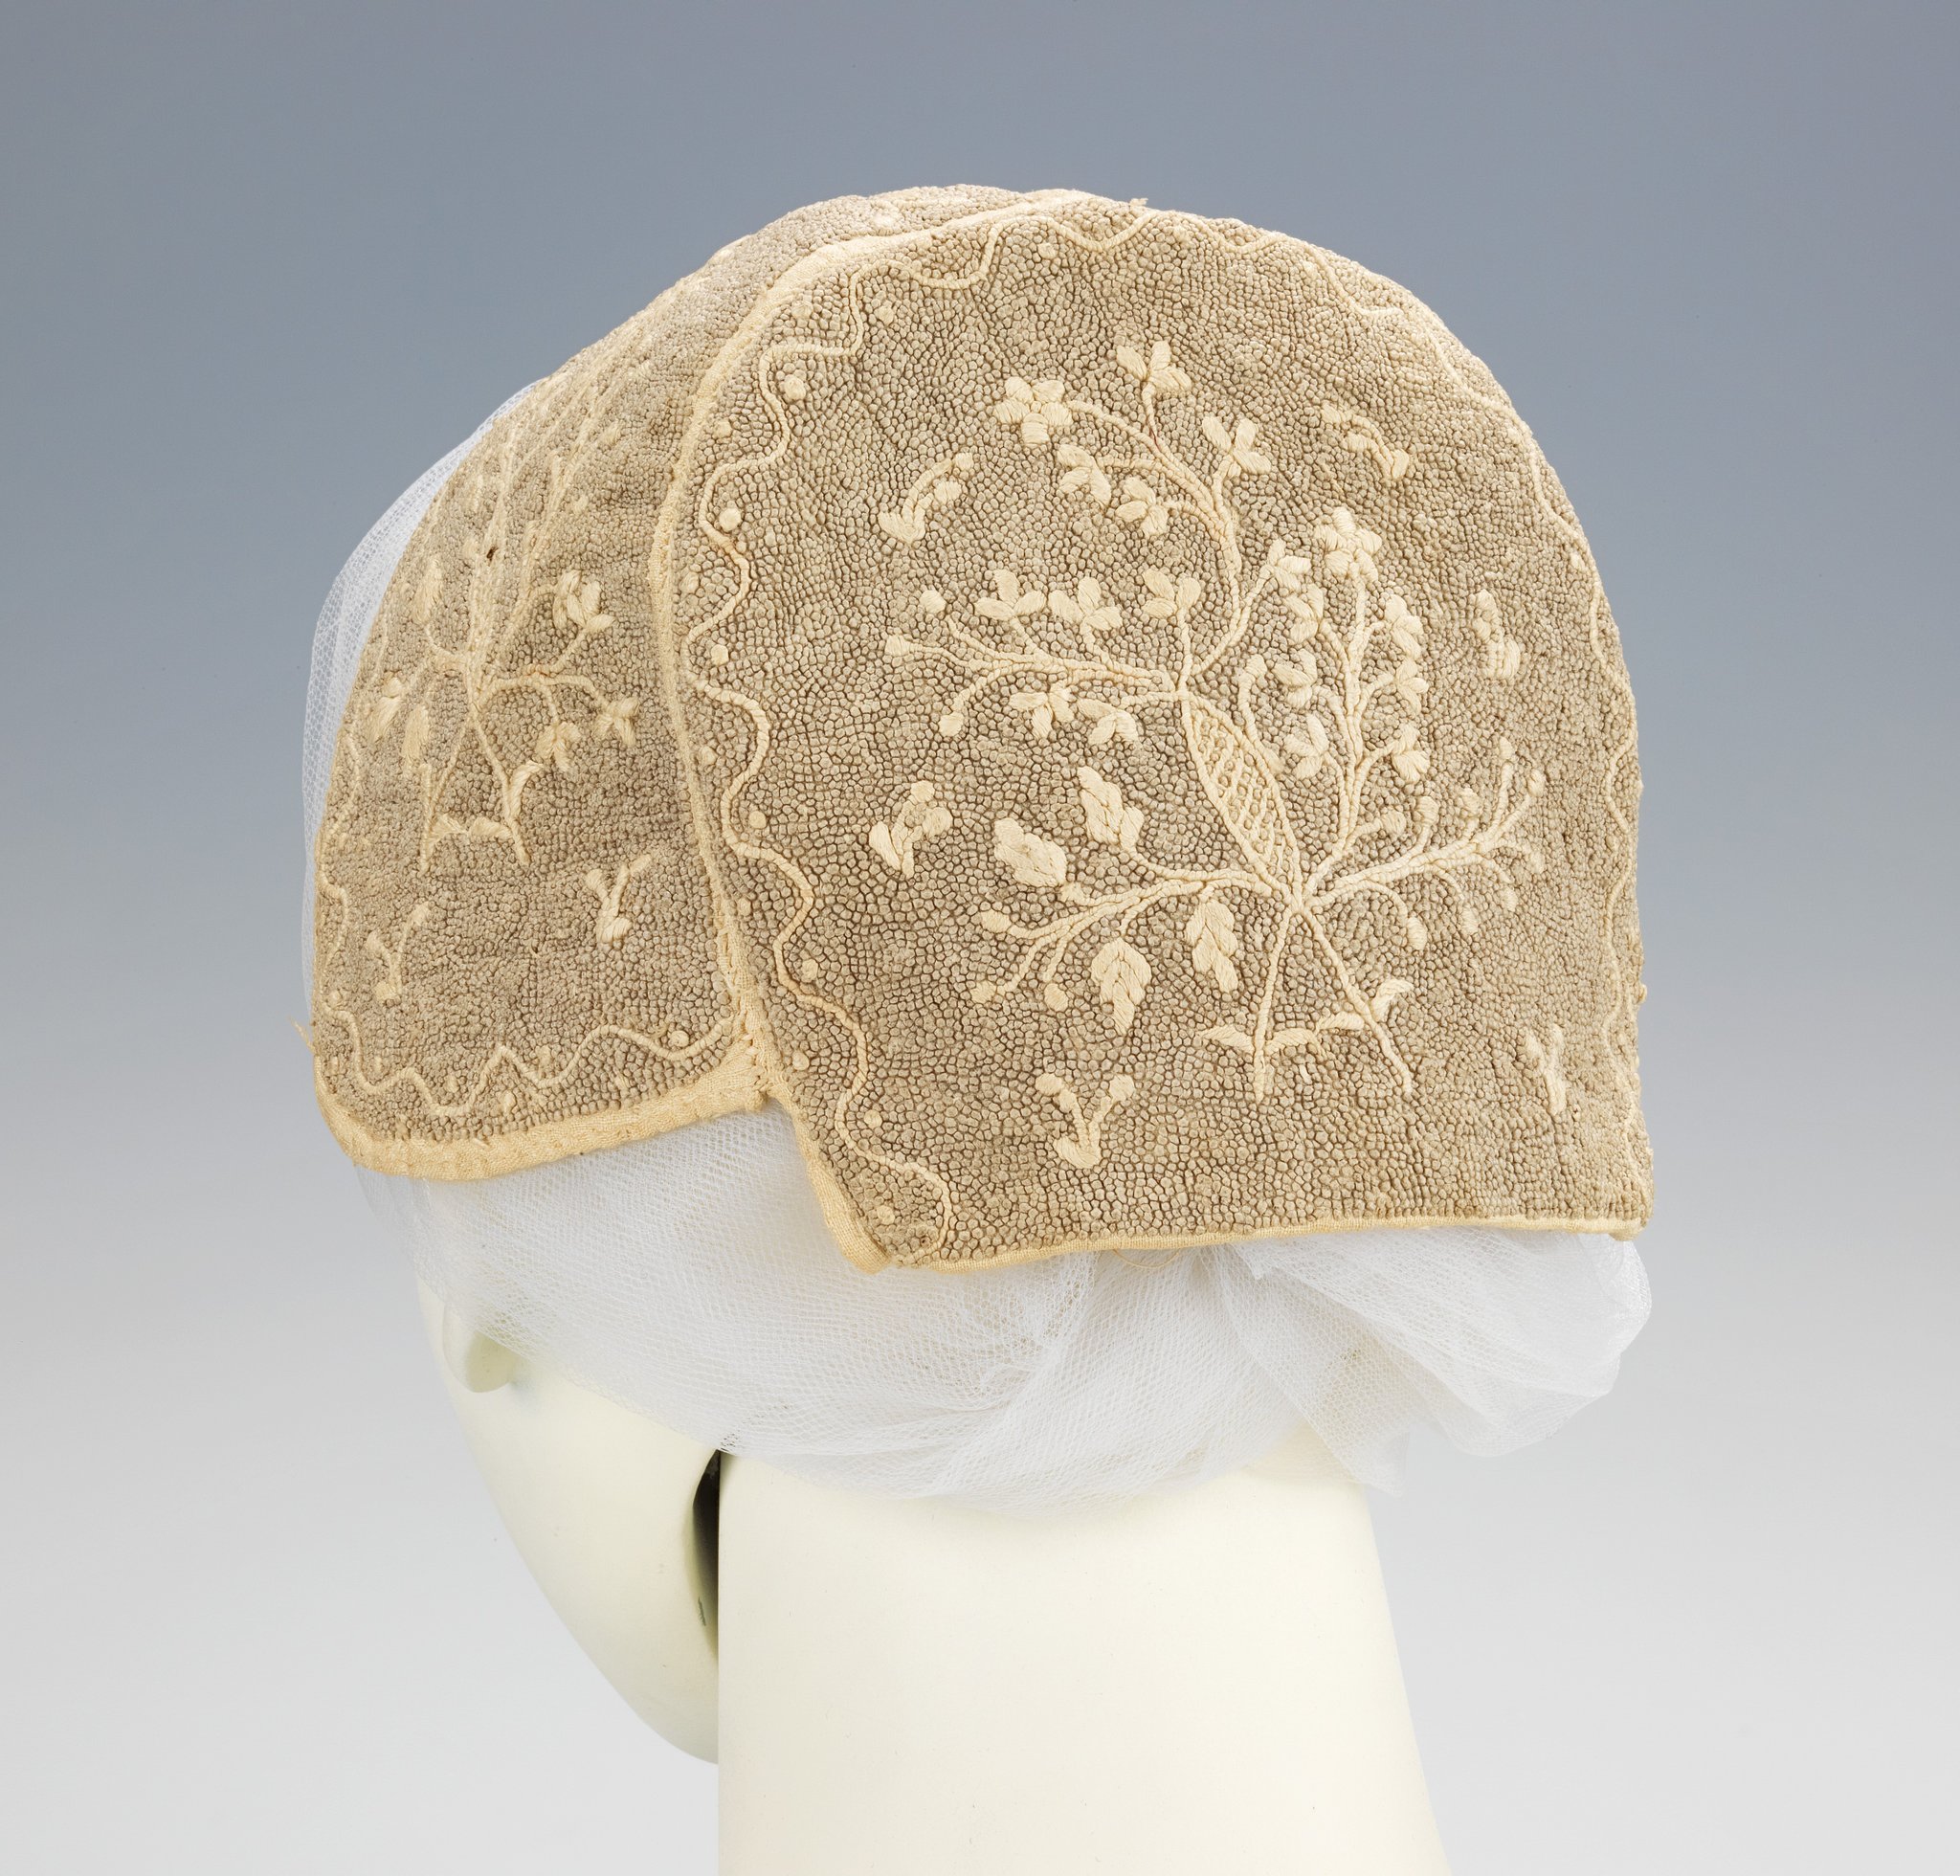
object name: cap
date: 1830-1850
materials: linen